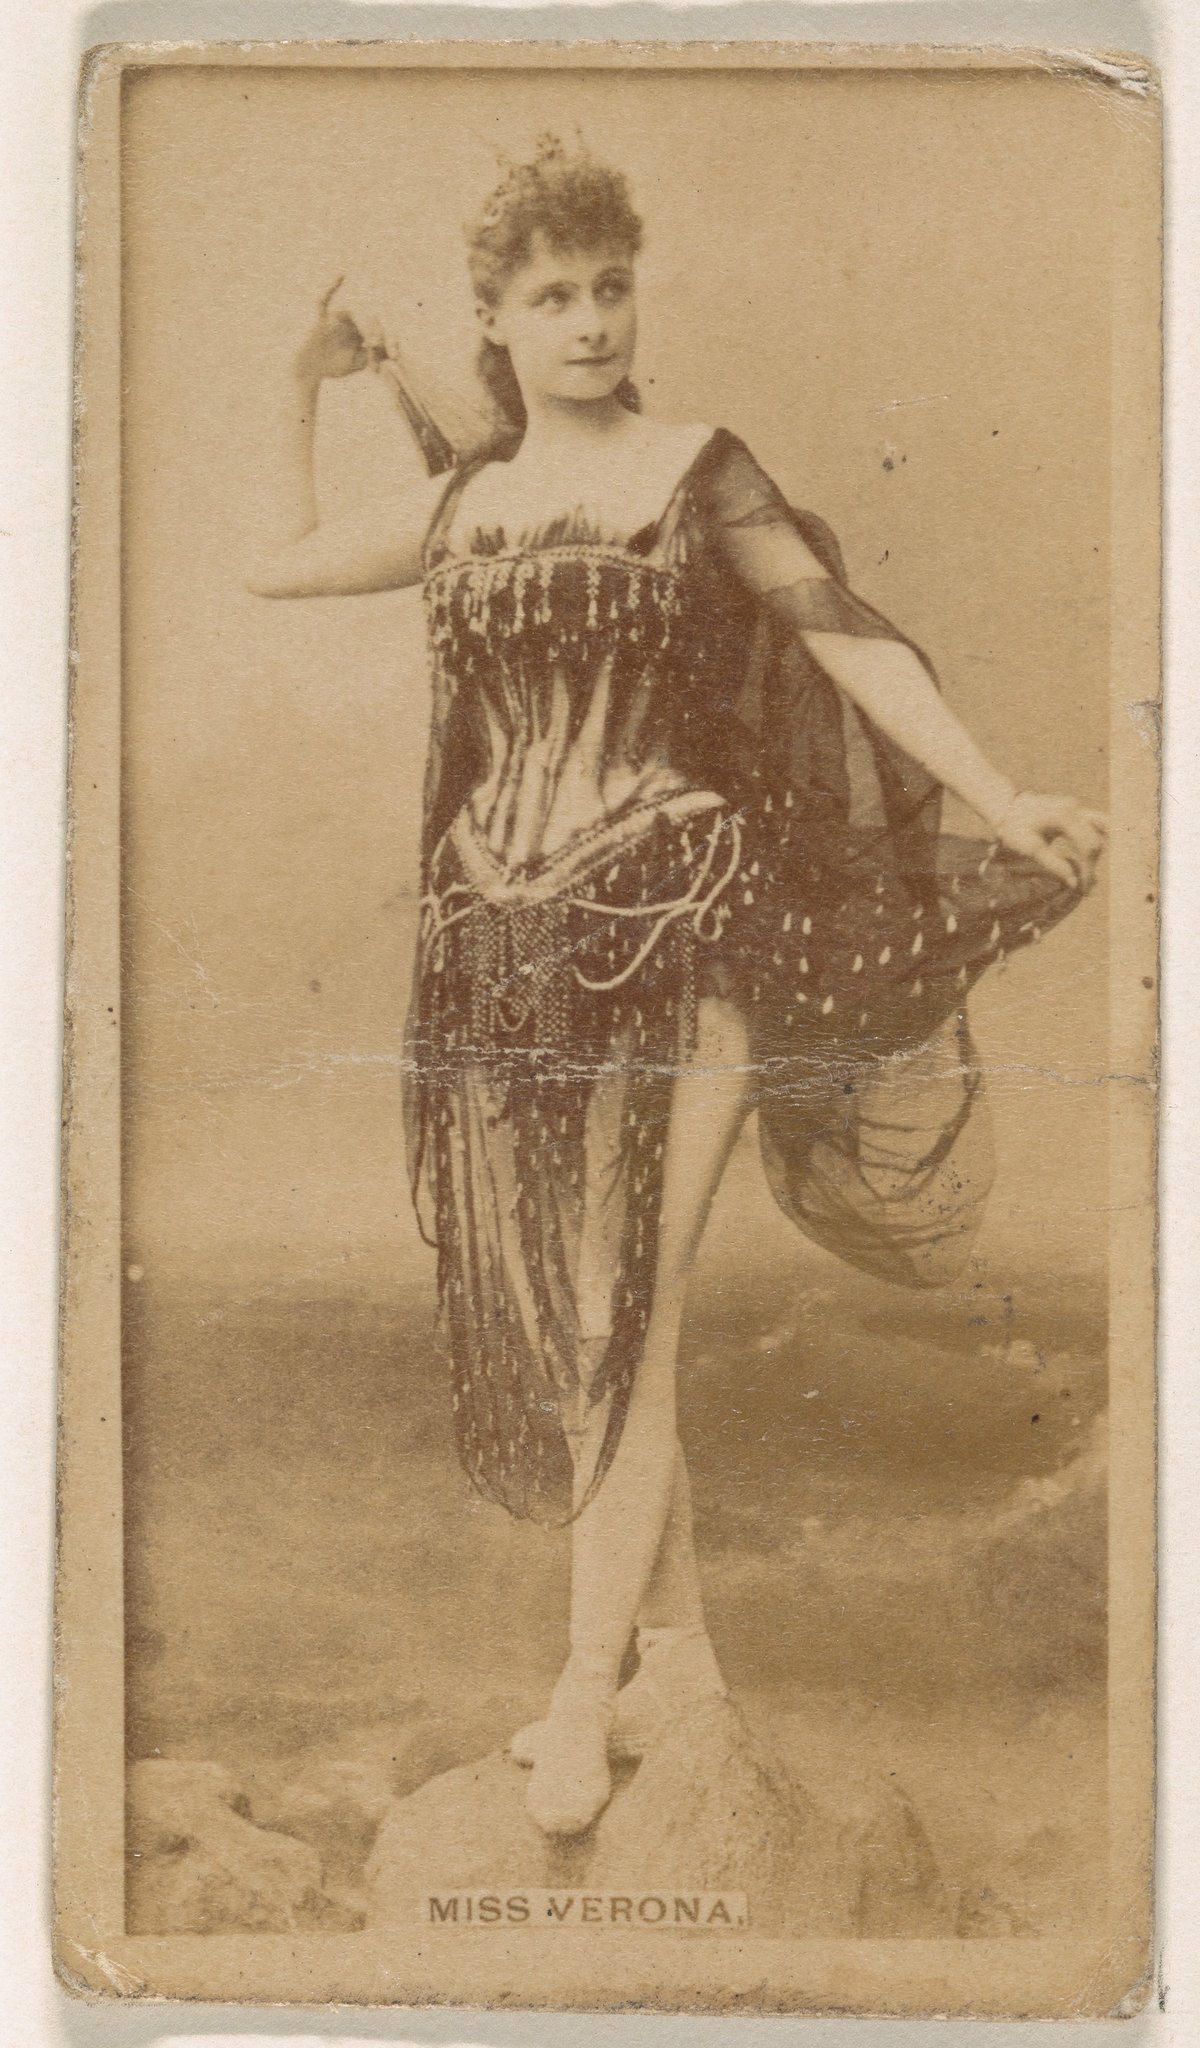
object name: photograph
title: Miss Verona, from the Actresses series (N245) issued by Kinney Brothers to promote Sweet Caporal Cigarettes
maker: kinney brothers tobacco company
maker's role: publisher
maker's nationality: american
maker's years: 1869-2011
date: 1890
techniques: albumen silver print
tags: portraits,women,actresses